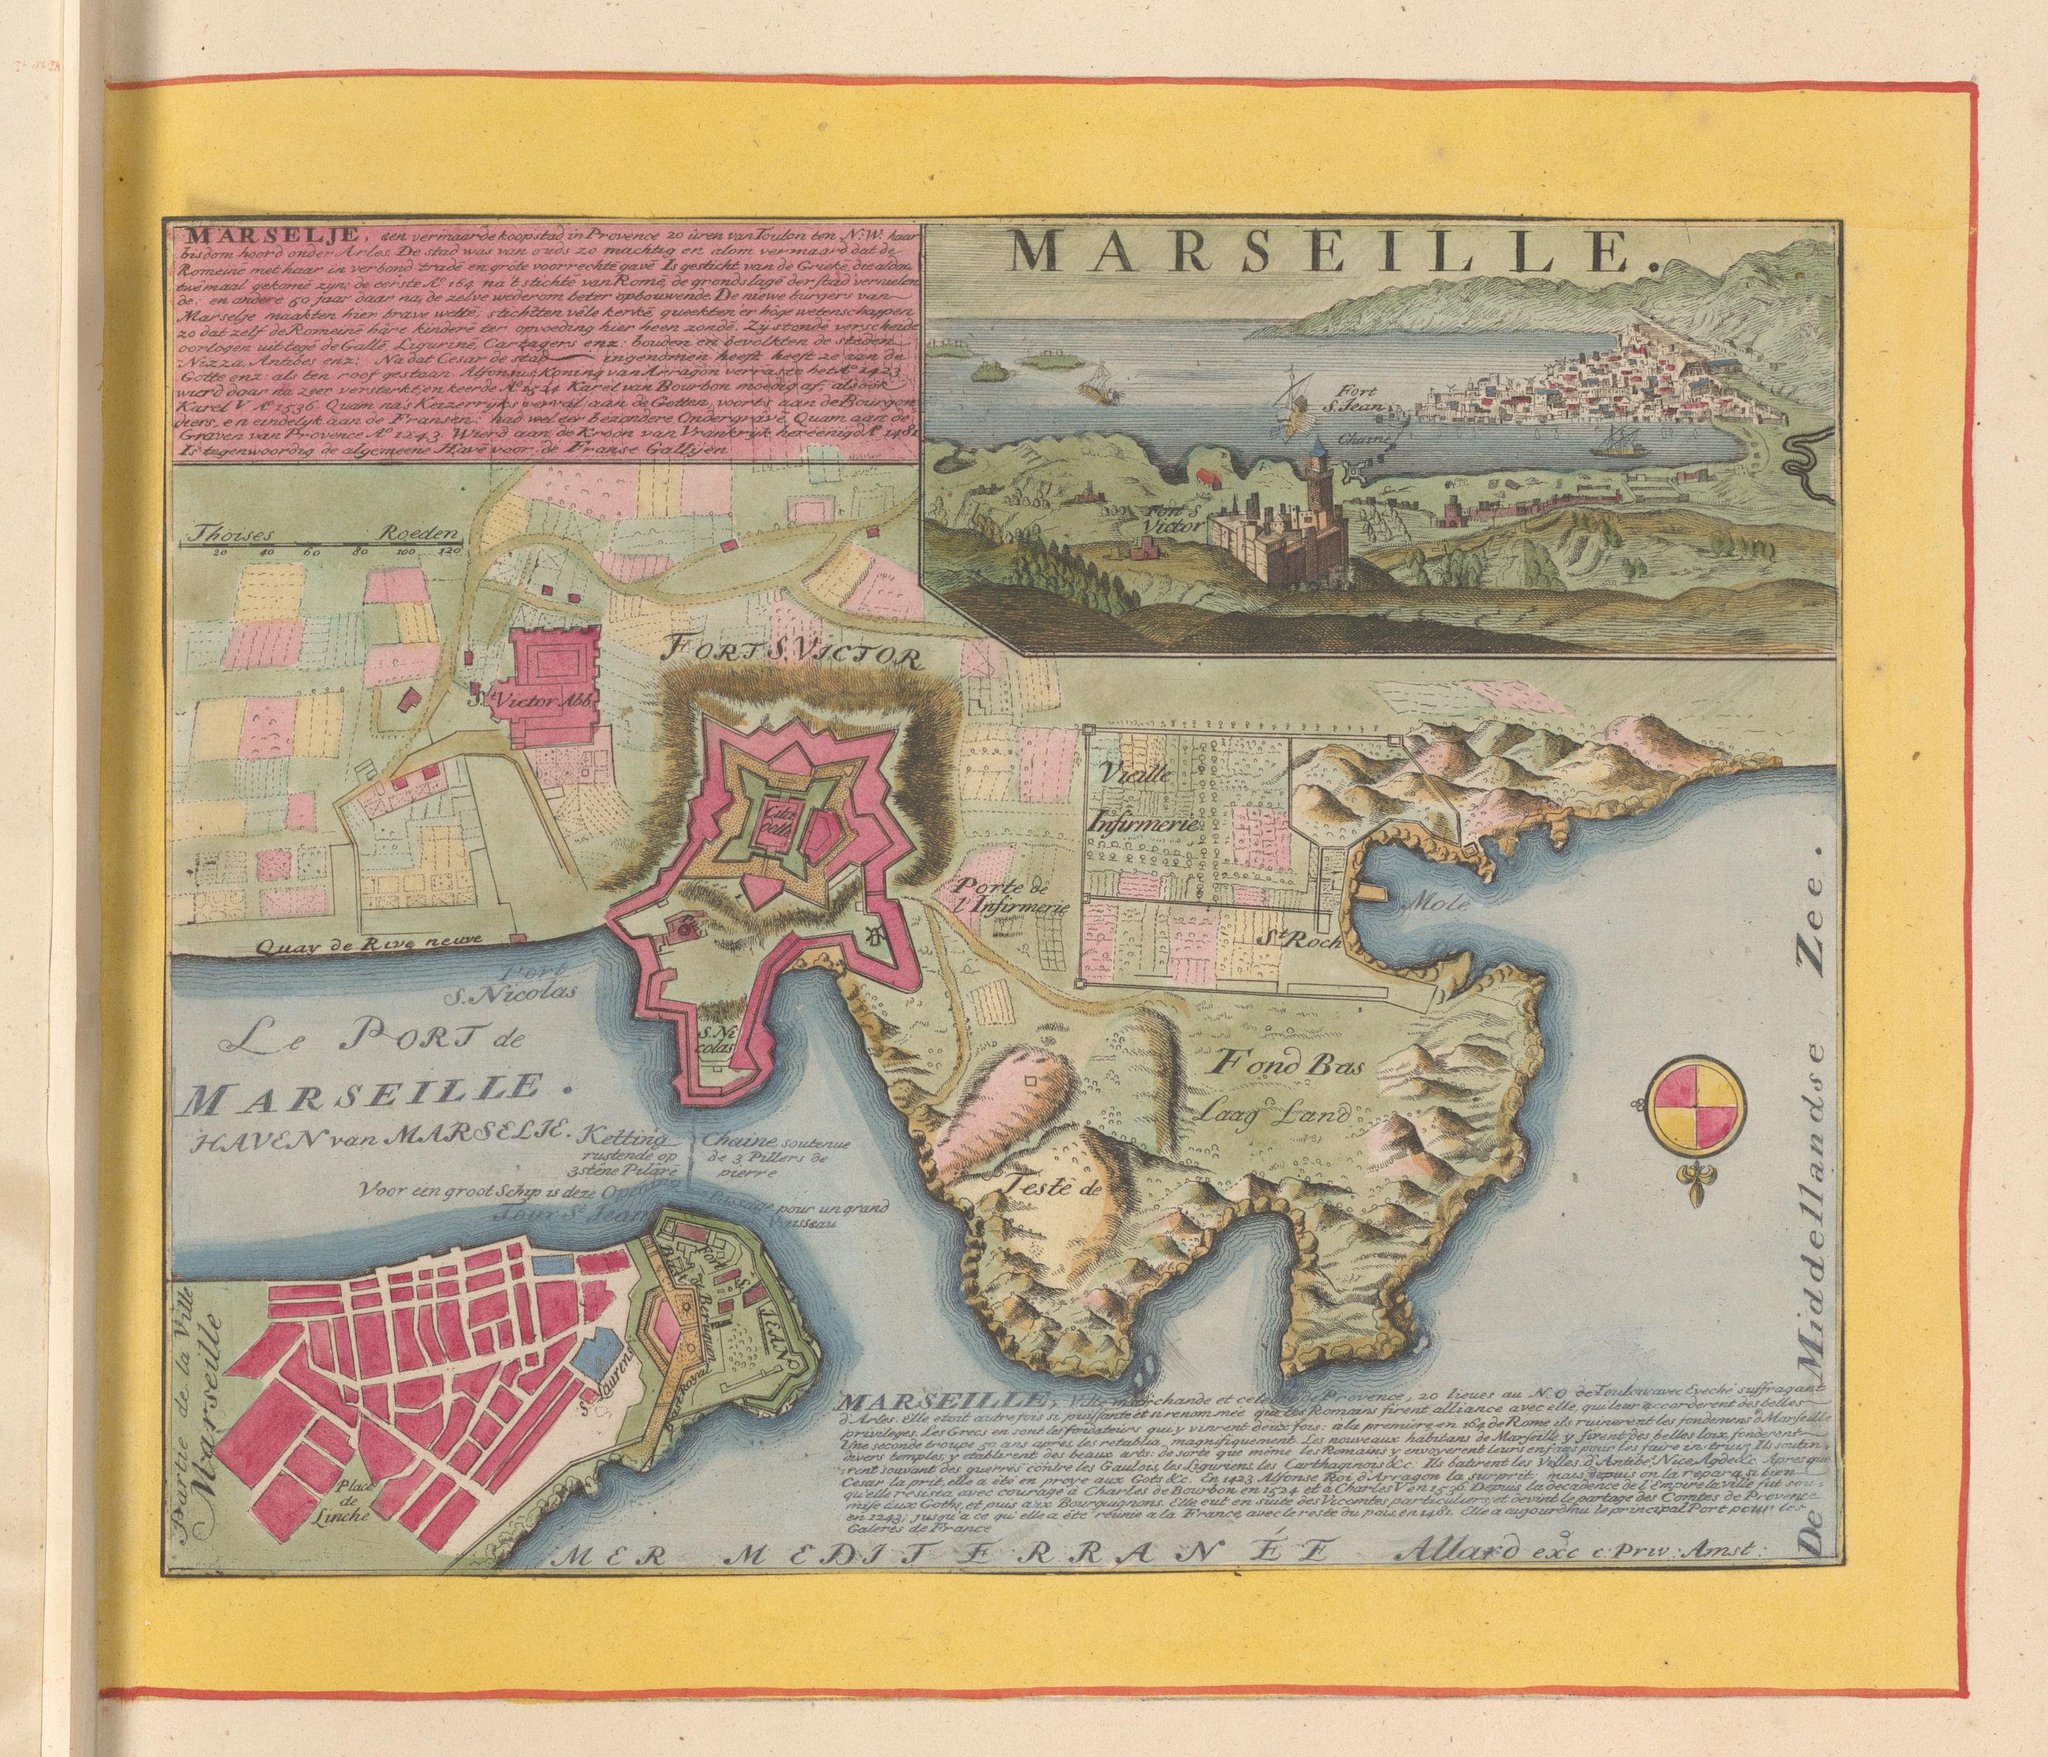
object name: area plan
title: Marselje, een vermaarde koopstad in Provence (...) / Marseille, ville marchande et celebre de Provence (...)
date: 1658-1709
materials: paper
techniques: engraving, etching, hand coloring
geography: amsterdam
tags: maps of cities, marseille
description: Rechts bovenin een inzet met gezicht op Marseille. De plattegrond centreert rond het fort Saint-Victor. Deze prent maakt deel uit van een album.